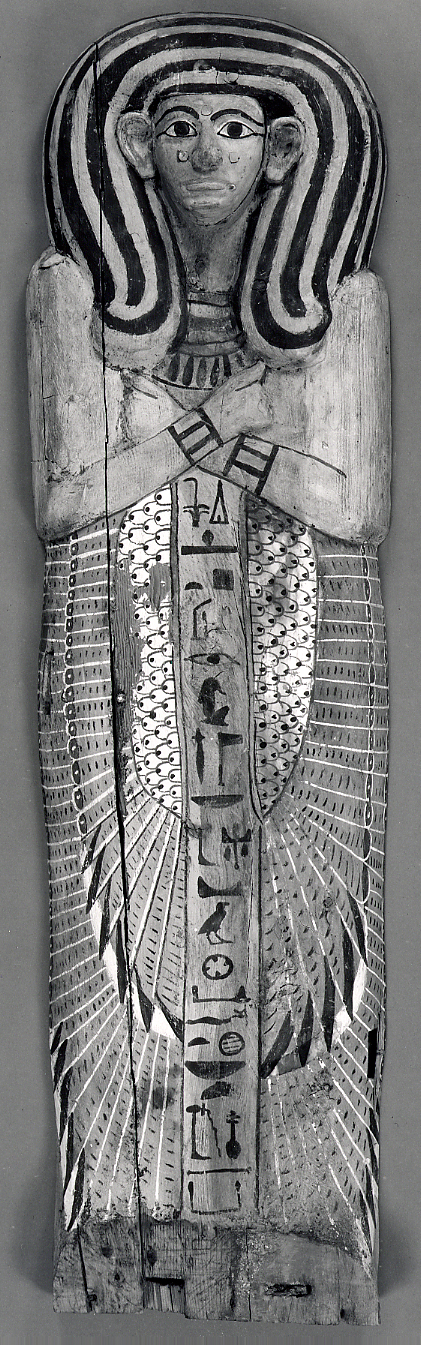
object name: coffin, rishi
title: Lid of Coffin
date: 1580-1479 BCE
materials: wood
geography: egypt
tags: women,hieroglyphs,coffins